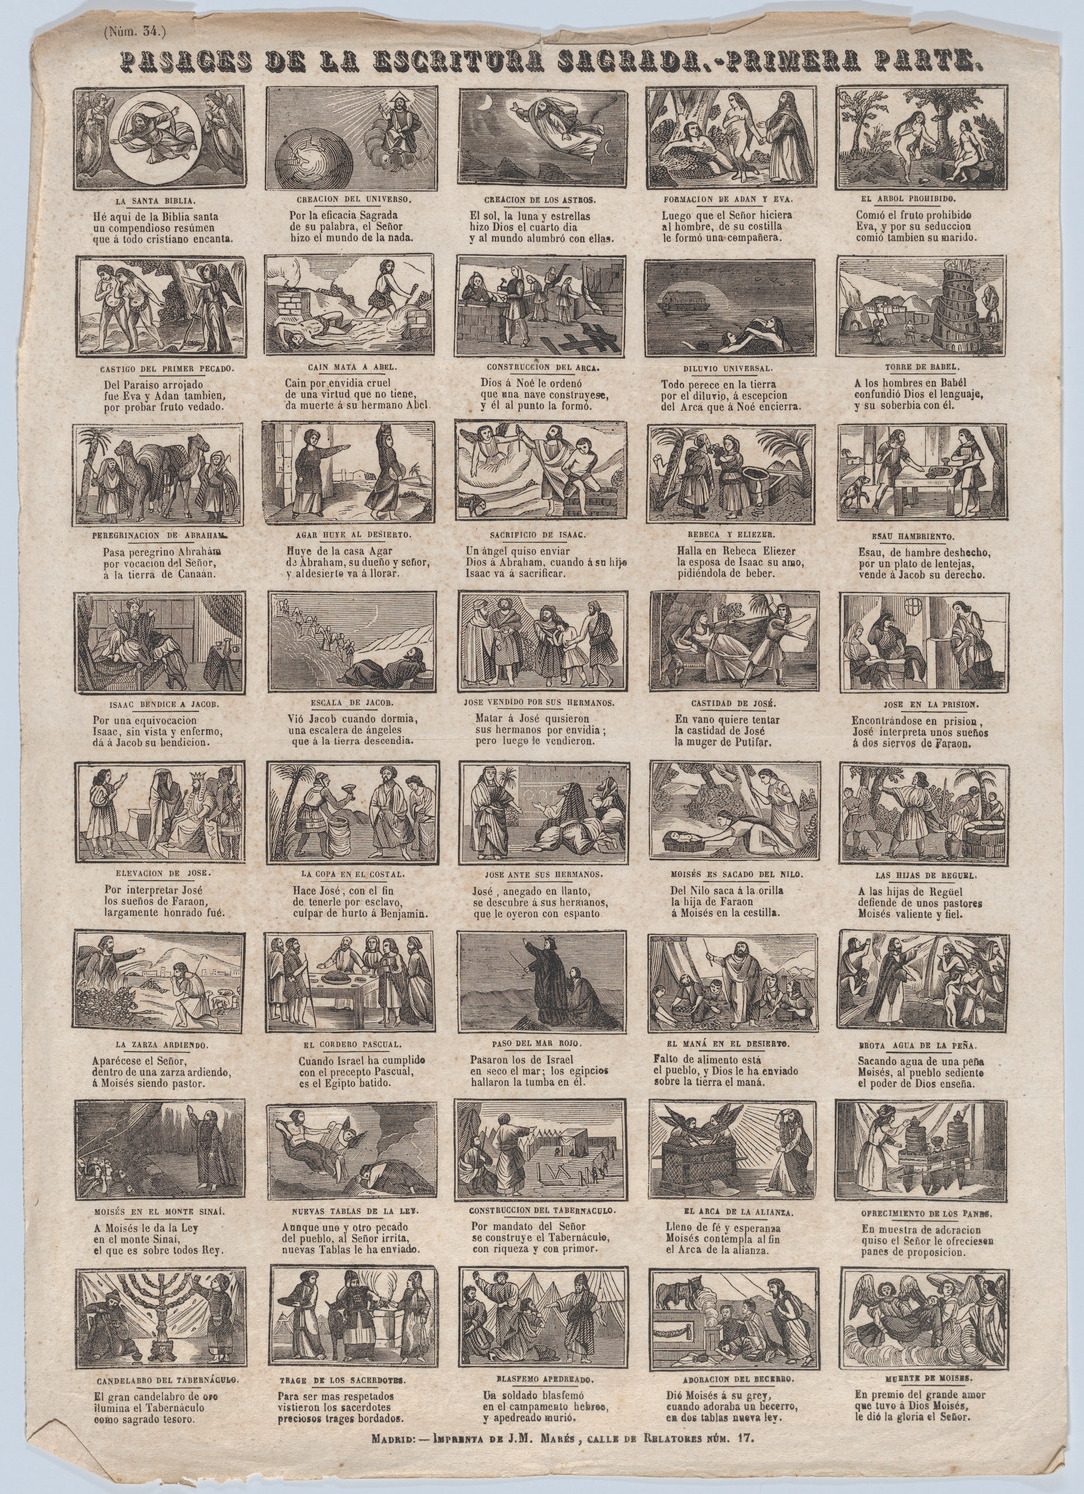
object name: print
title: Broadside with 48 scenes illustrating passages of holy scripture (Part I)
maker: josé maría marés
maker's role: publisher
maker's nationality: spanish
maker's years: 1850-1870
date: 1860-1870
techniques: engraving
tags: men,angels,jesus